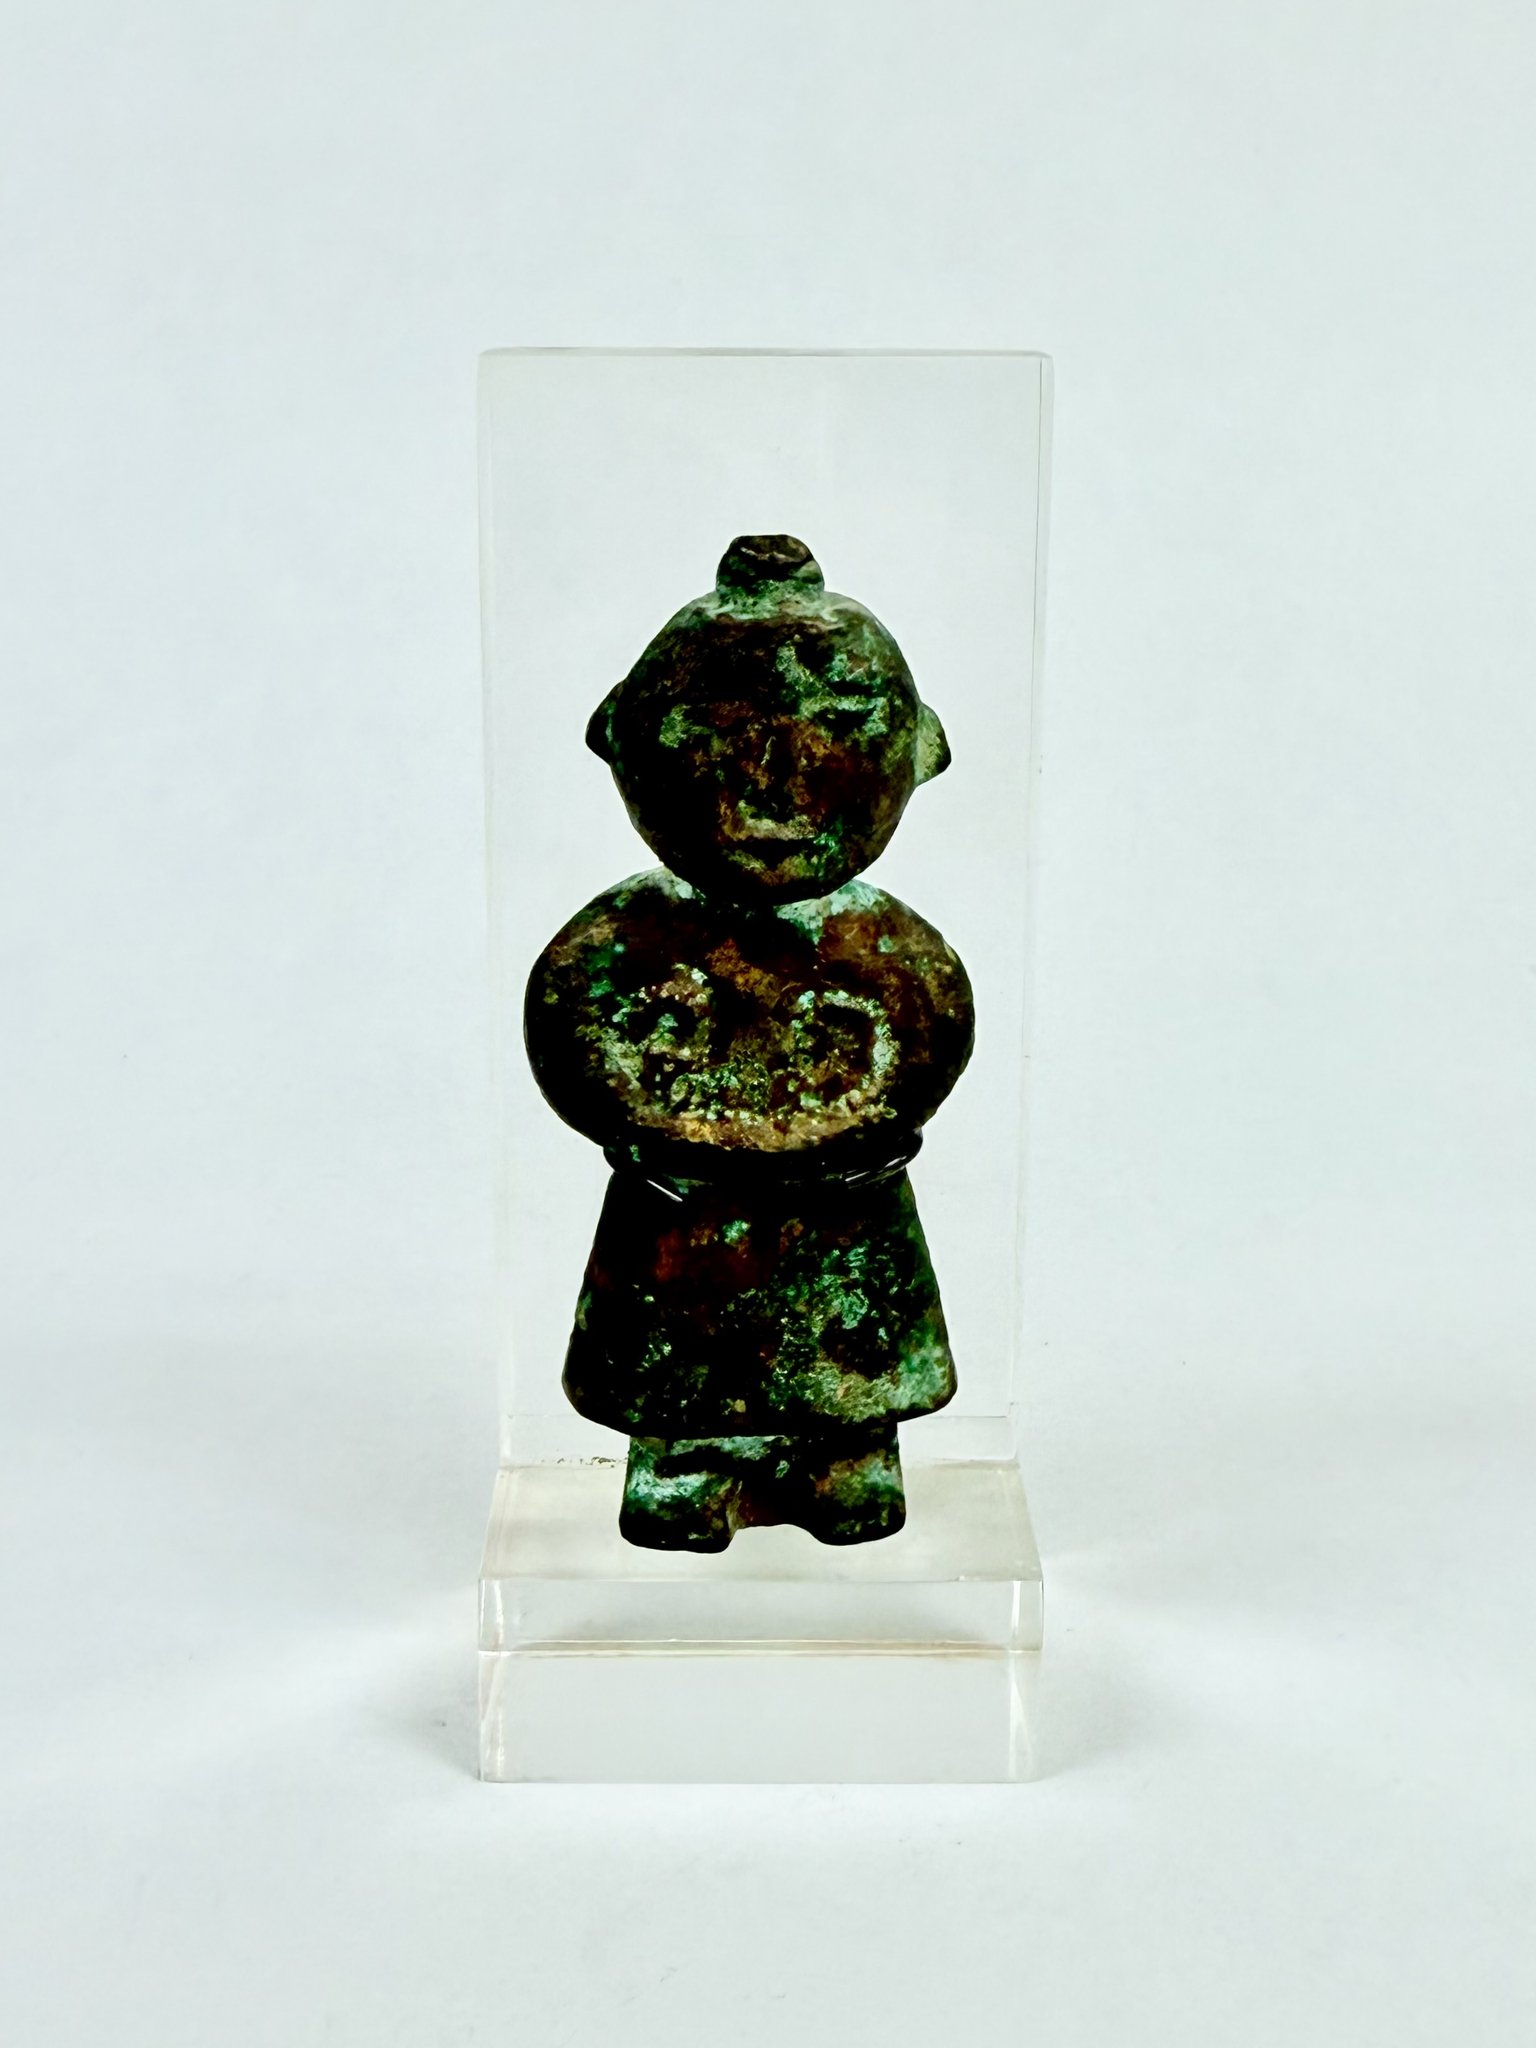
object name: figure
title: Standing figure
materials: bronze